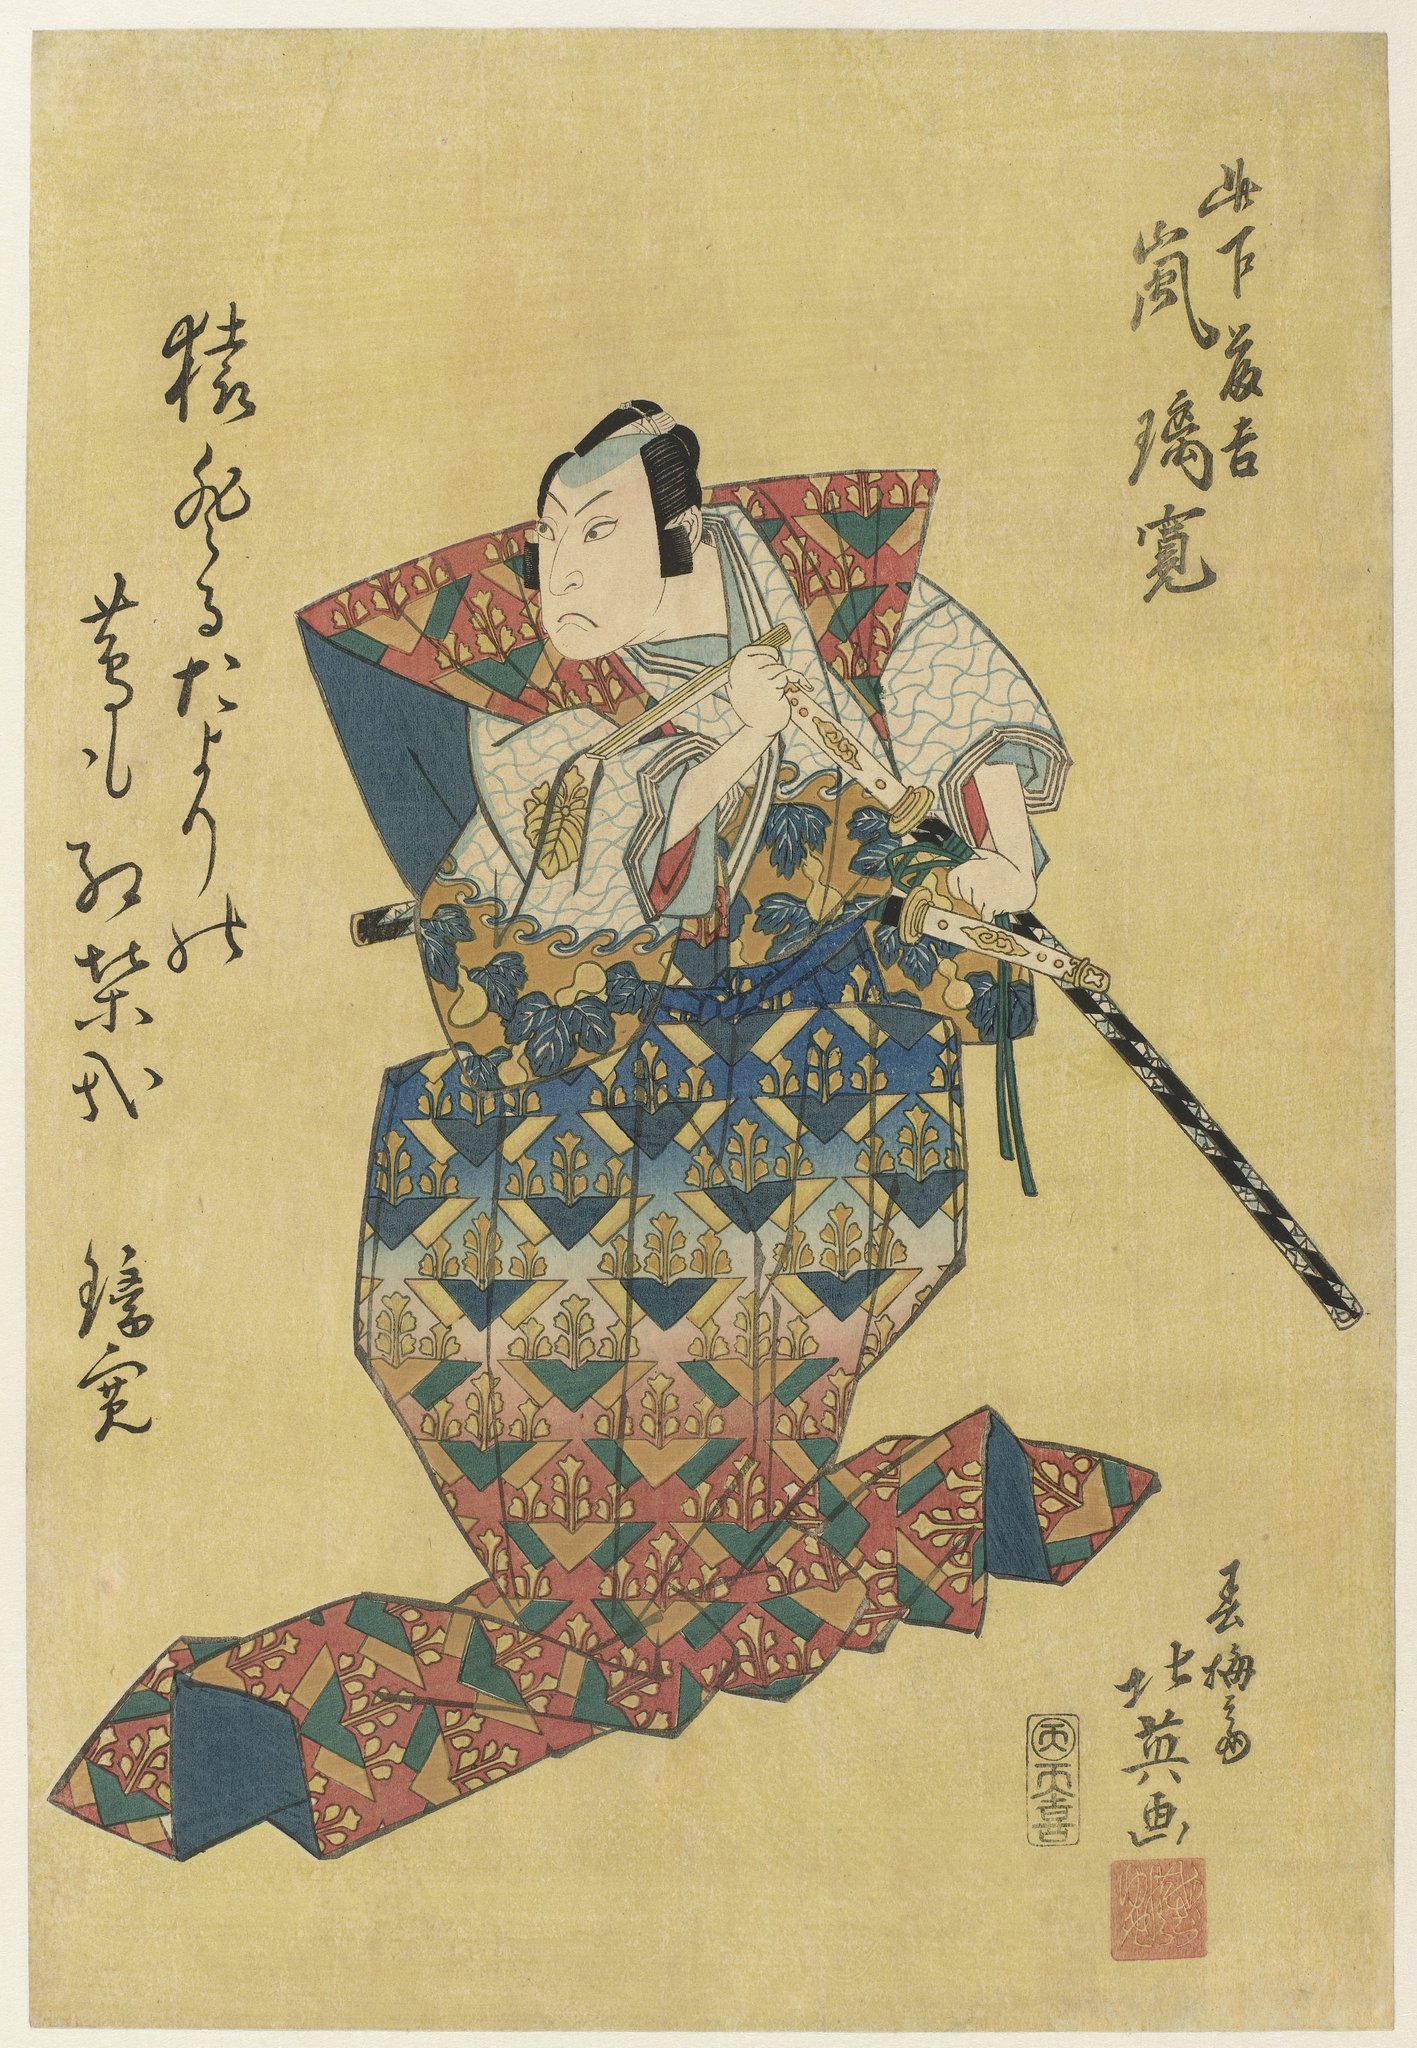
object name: print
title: Arashi Rikan II als Konoshita Tôkichi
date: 1835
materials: paper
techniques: woodcut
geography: osaka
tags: hacking and thrusting weapons: sword, actor (on the stage)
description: Toneelspeler Arashi Rikan II in de rol van Konoshita Tôkichi, tegen gele achtergrond. Scene uit het toneelstuk "Konoshita kage hazama gassen", opgevoerd in het Naka Theater, in de negende maand van 1835. Met een gedicht gesigneerd door de auteur "Rikan".